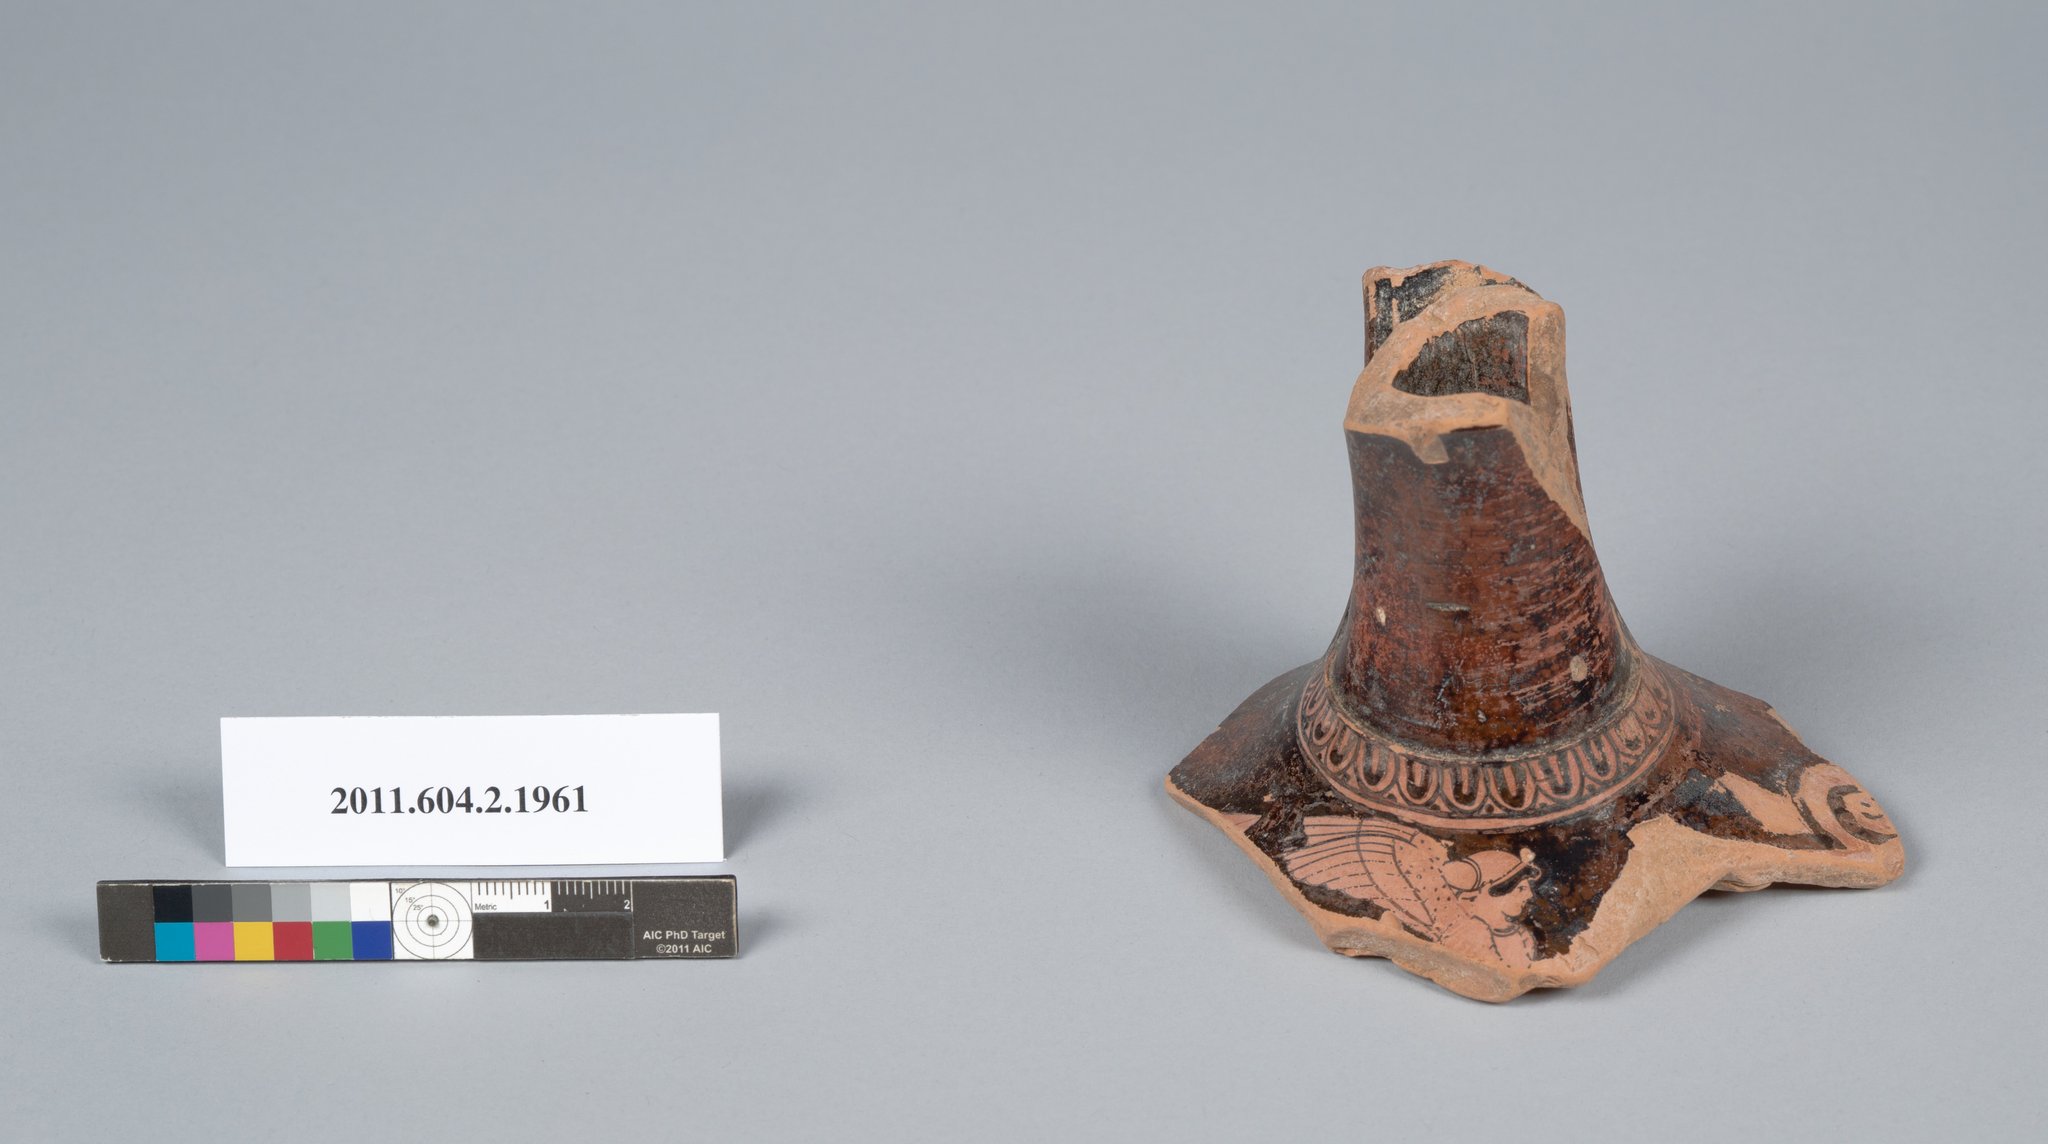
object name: lekythos fragment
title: Terracotta fragment of a lekythos (oil flask)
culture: greek, attic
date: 475-451 BCE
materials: terracotta